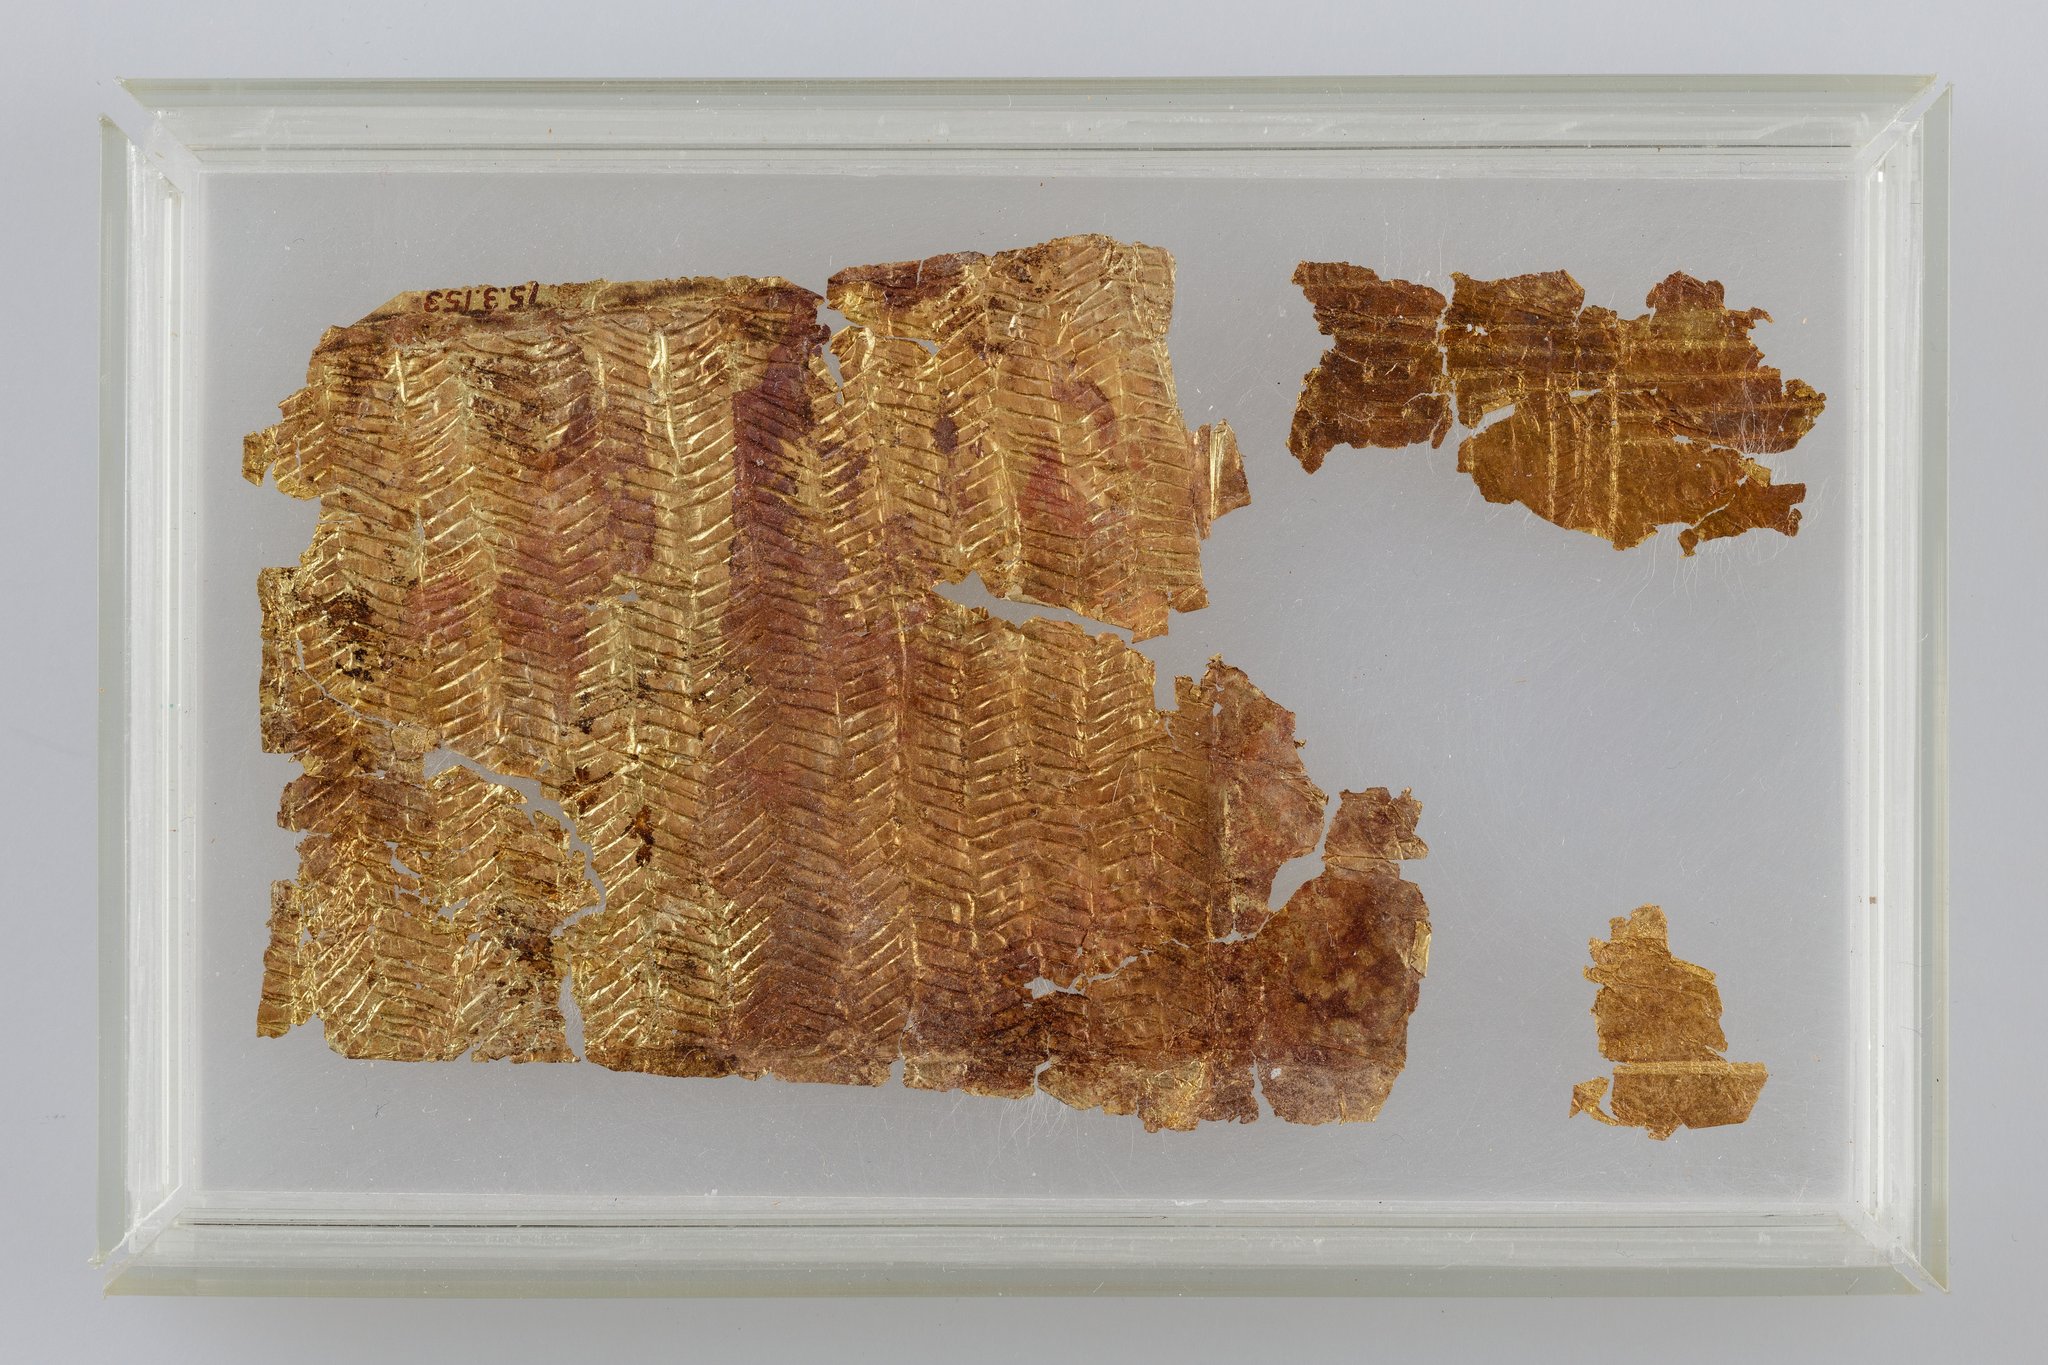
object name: gold fragment from shabti check name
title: Gold leaf from shabti of Neferseneb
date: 1850-1640 BCE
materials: gold leaf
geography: egypt